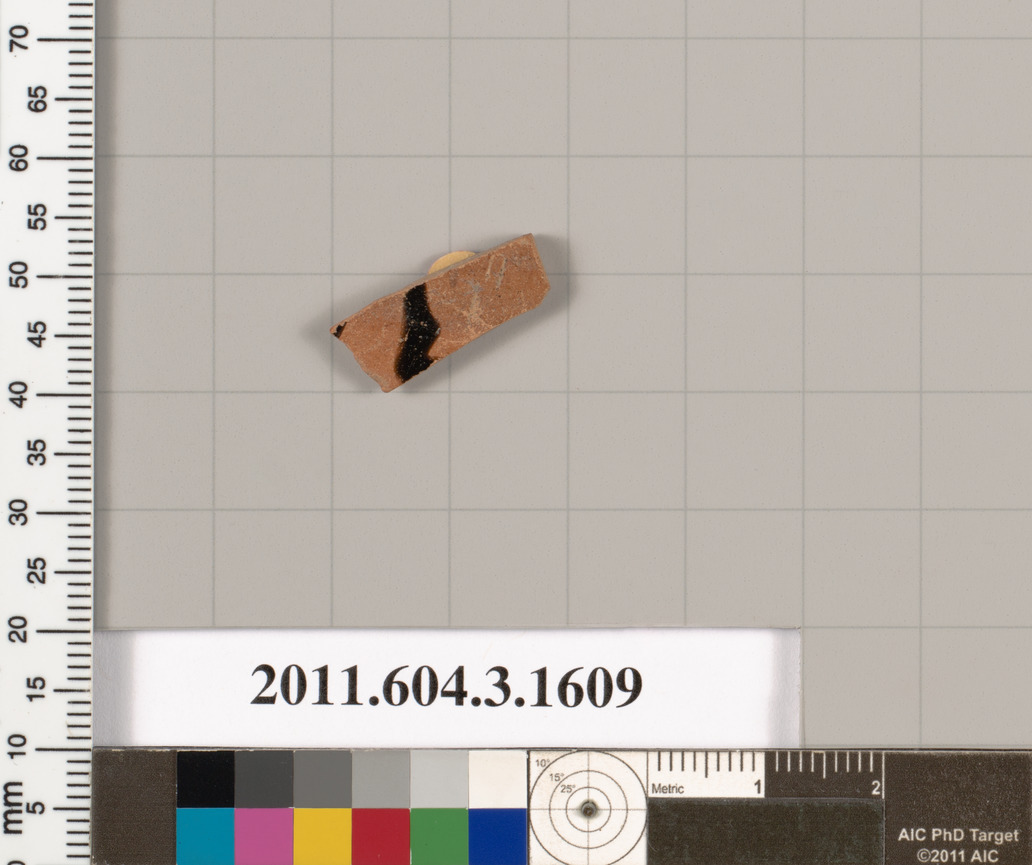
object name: kylix fragment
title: Terracotta fragment of a kylix: Band cup (drinking cup)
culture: greek, attic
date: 550-526 BCE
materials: terracotta